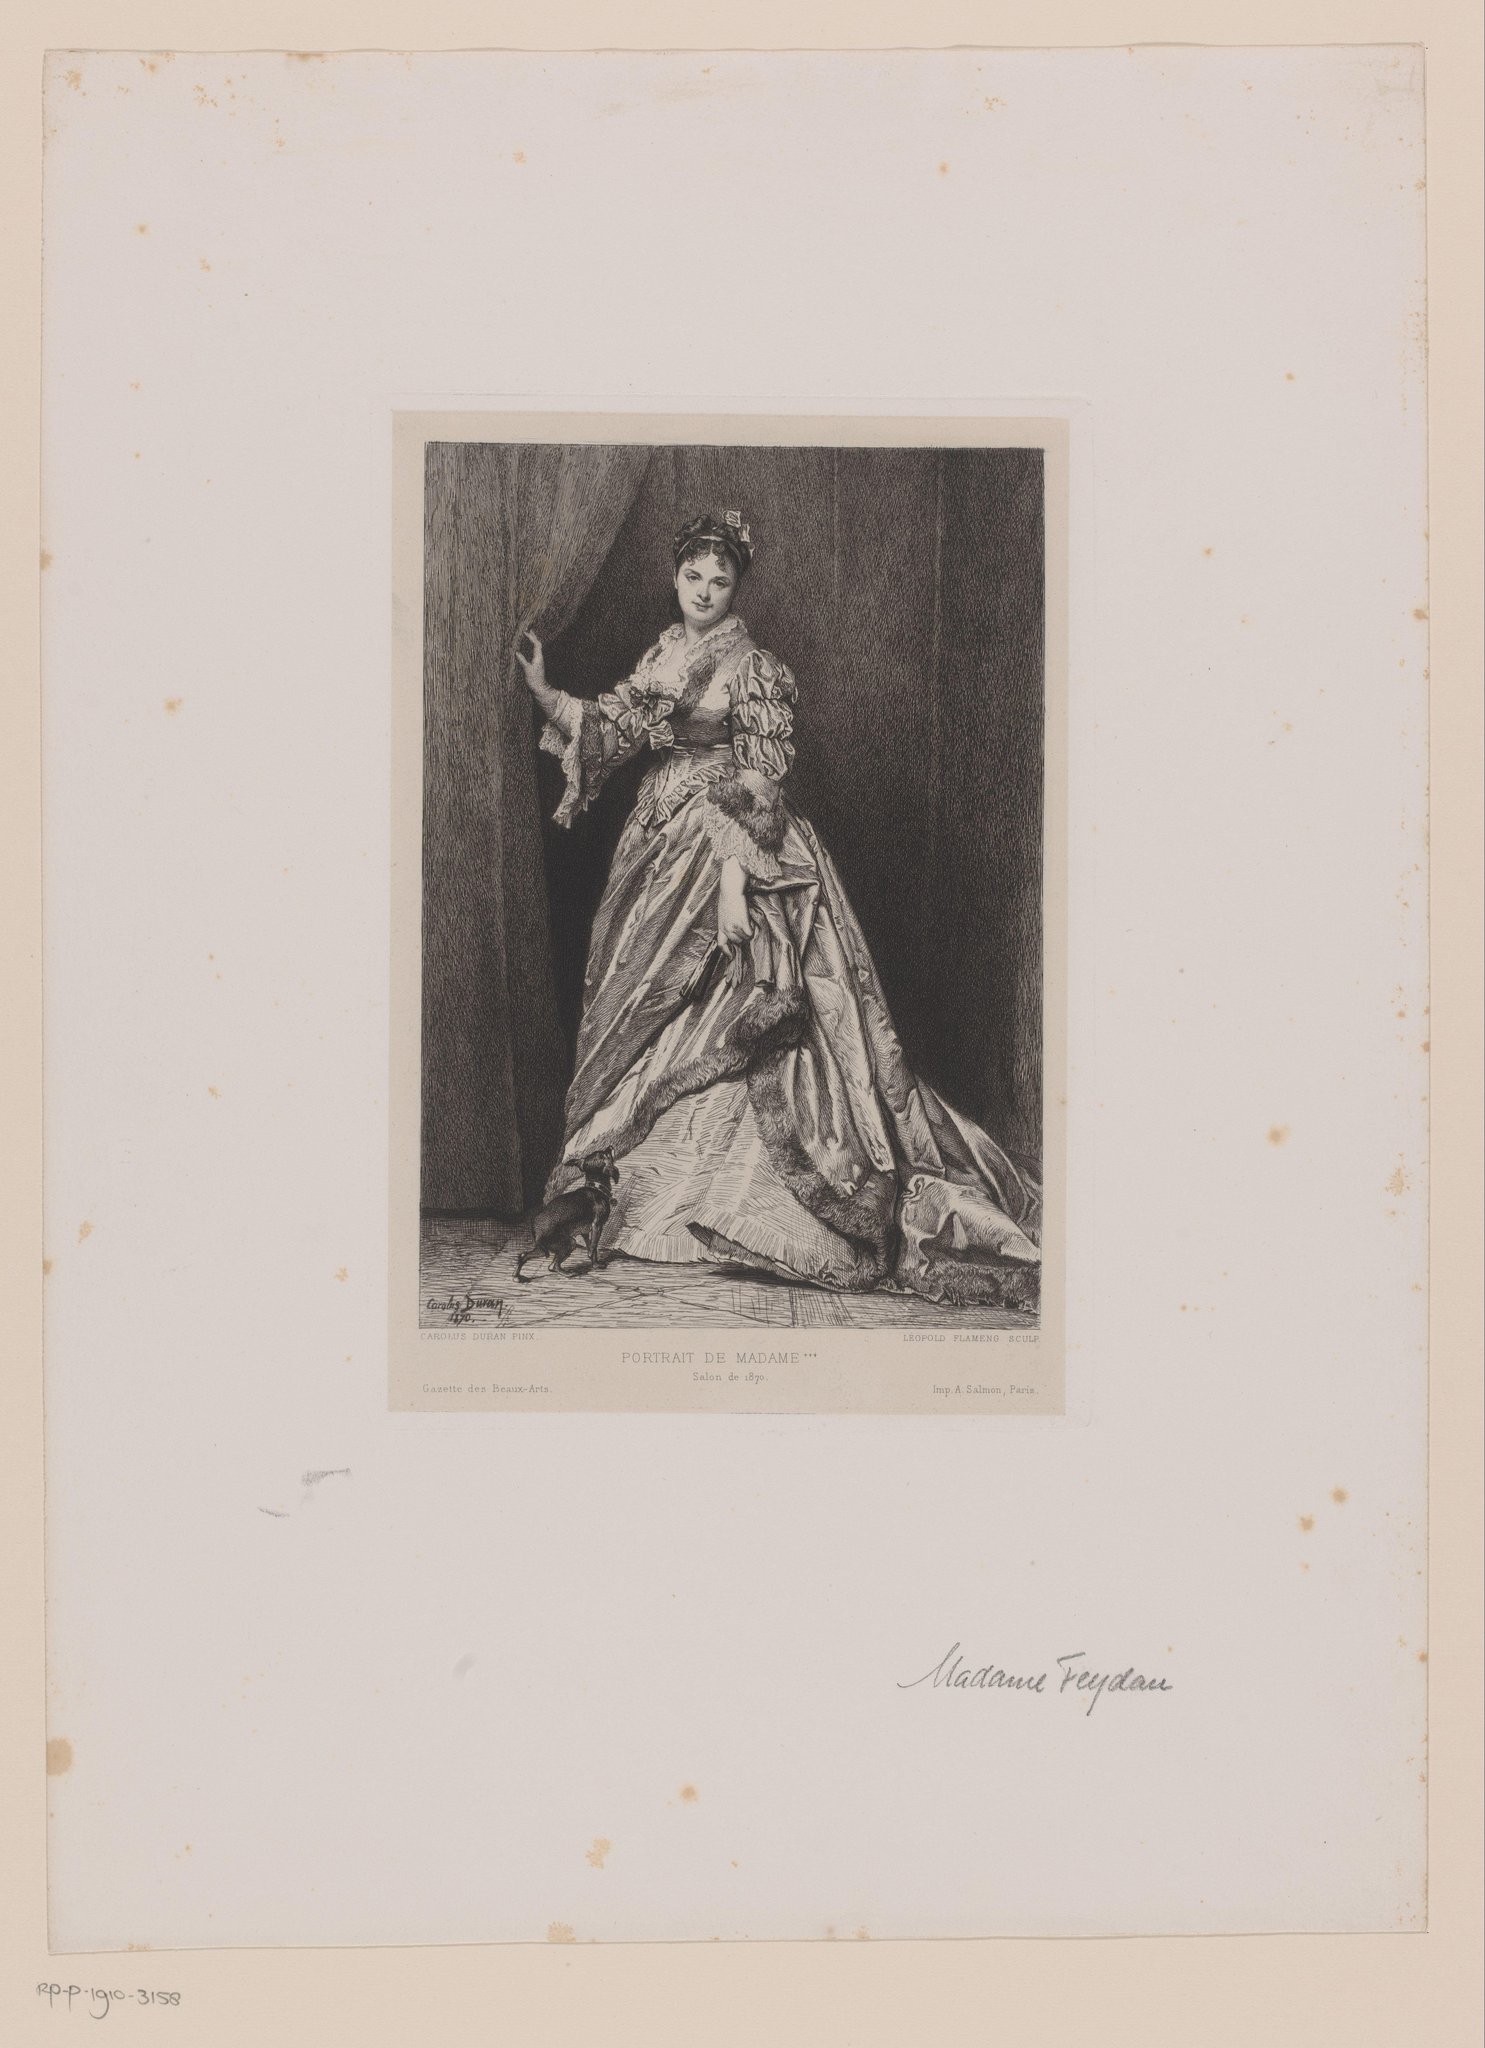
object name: print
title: Portrait de Madame ***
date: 1870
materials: paper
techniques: etching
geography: paris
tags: historical persons - bb - woman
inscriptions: collector's mark: Lugt 2228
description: Mevrouw Zelewska was getrouwd met dhr. Ernest Feydeau. Om die reden staat deze prent ook bekend als Portrait de Madame Feydeau. Prent uit: Gazette des beaux-arts. Parijs: J. Claye, 1870, dl. 2, p. 70.